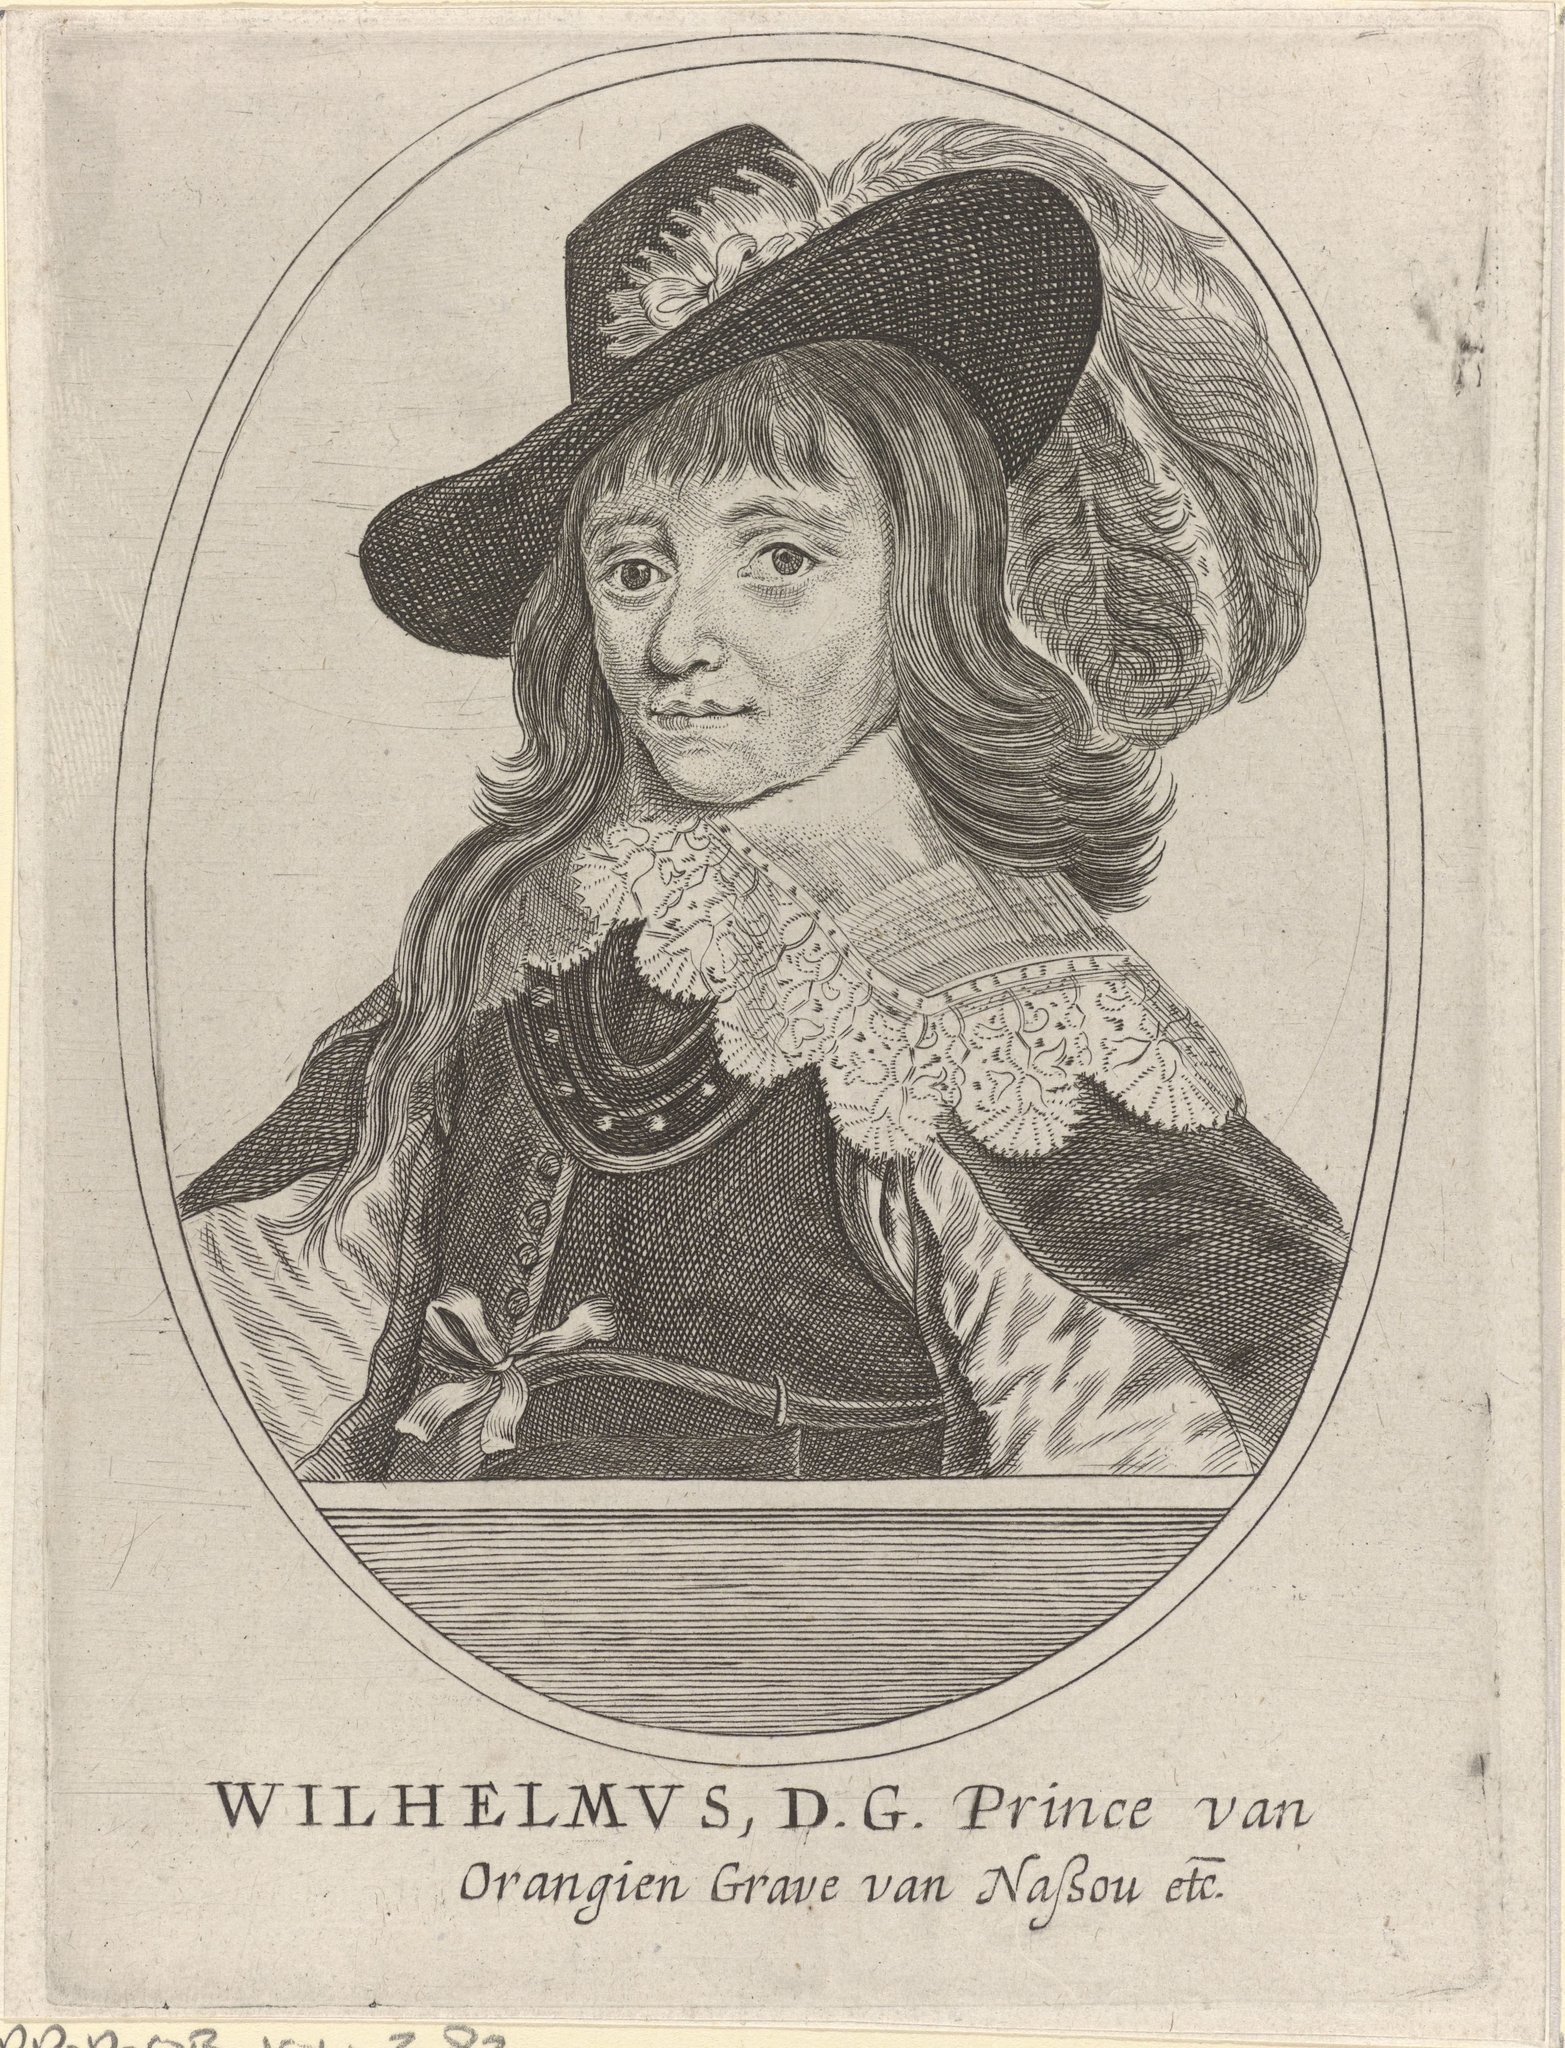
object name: print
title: Portret van Willem II, prins van Oranje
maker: Anonymous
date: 1650-1749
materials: paper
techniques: engraving, etching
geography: low countries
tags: william ii (prince of orange)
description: De hier vermelde titel verwijst naar de hoogst verkregen titel van de geportretteerde, niet per se naar de titel die de geportretteerde op deze voorstelling draagt.